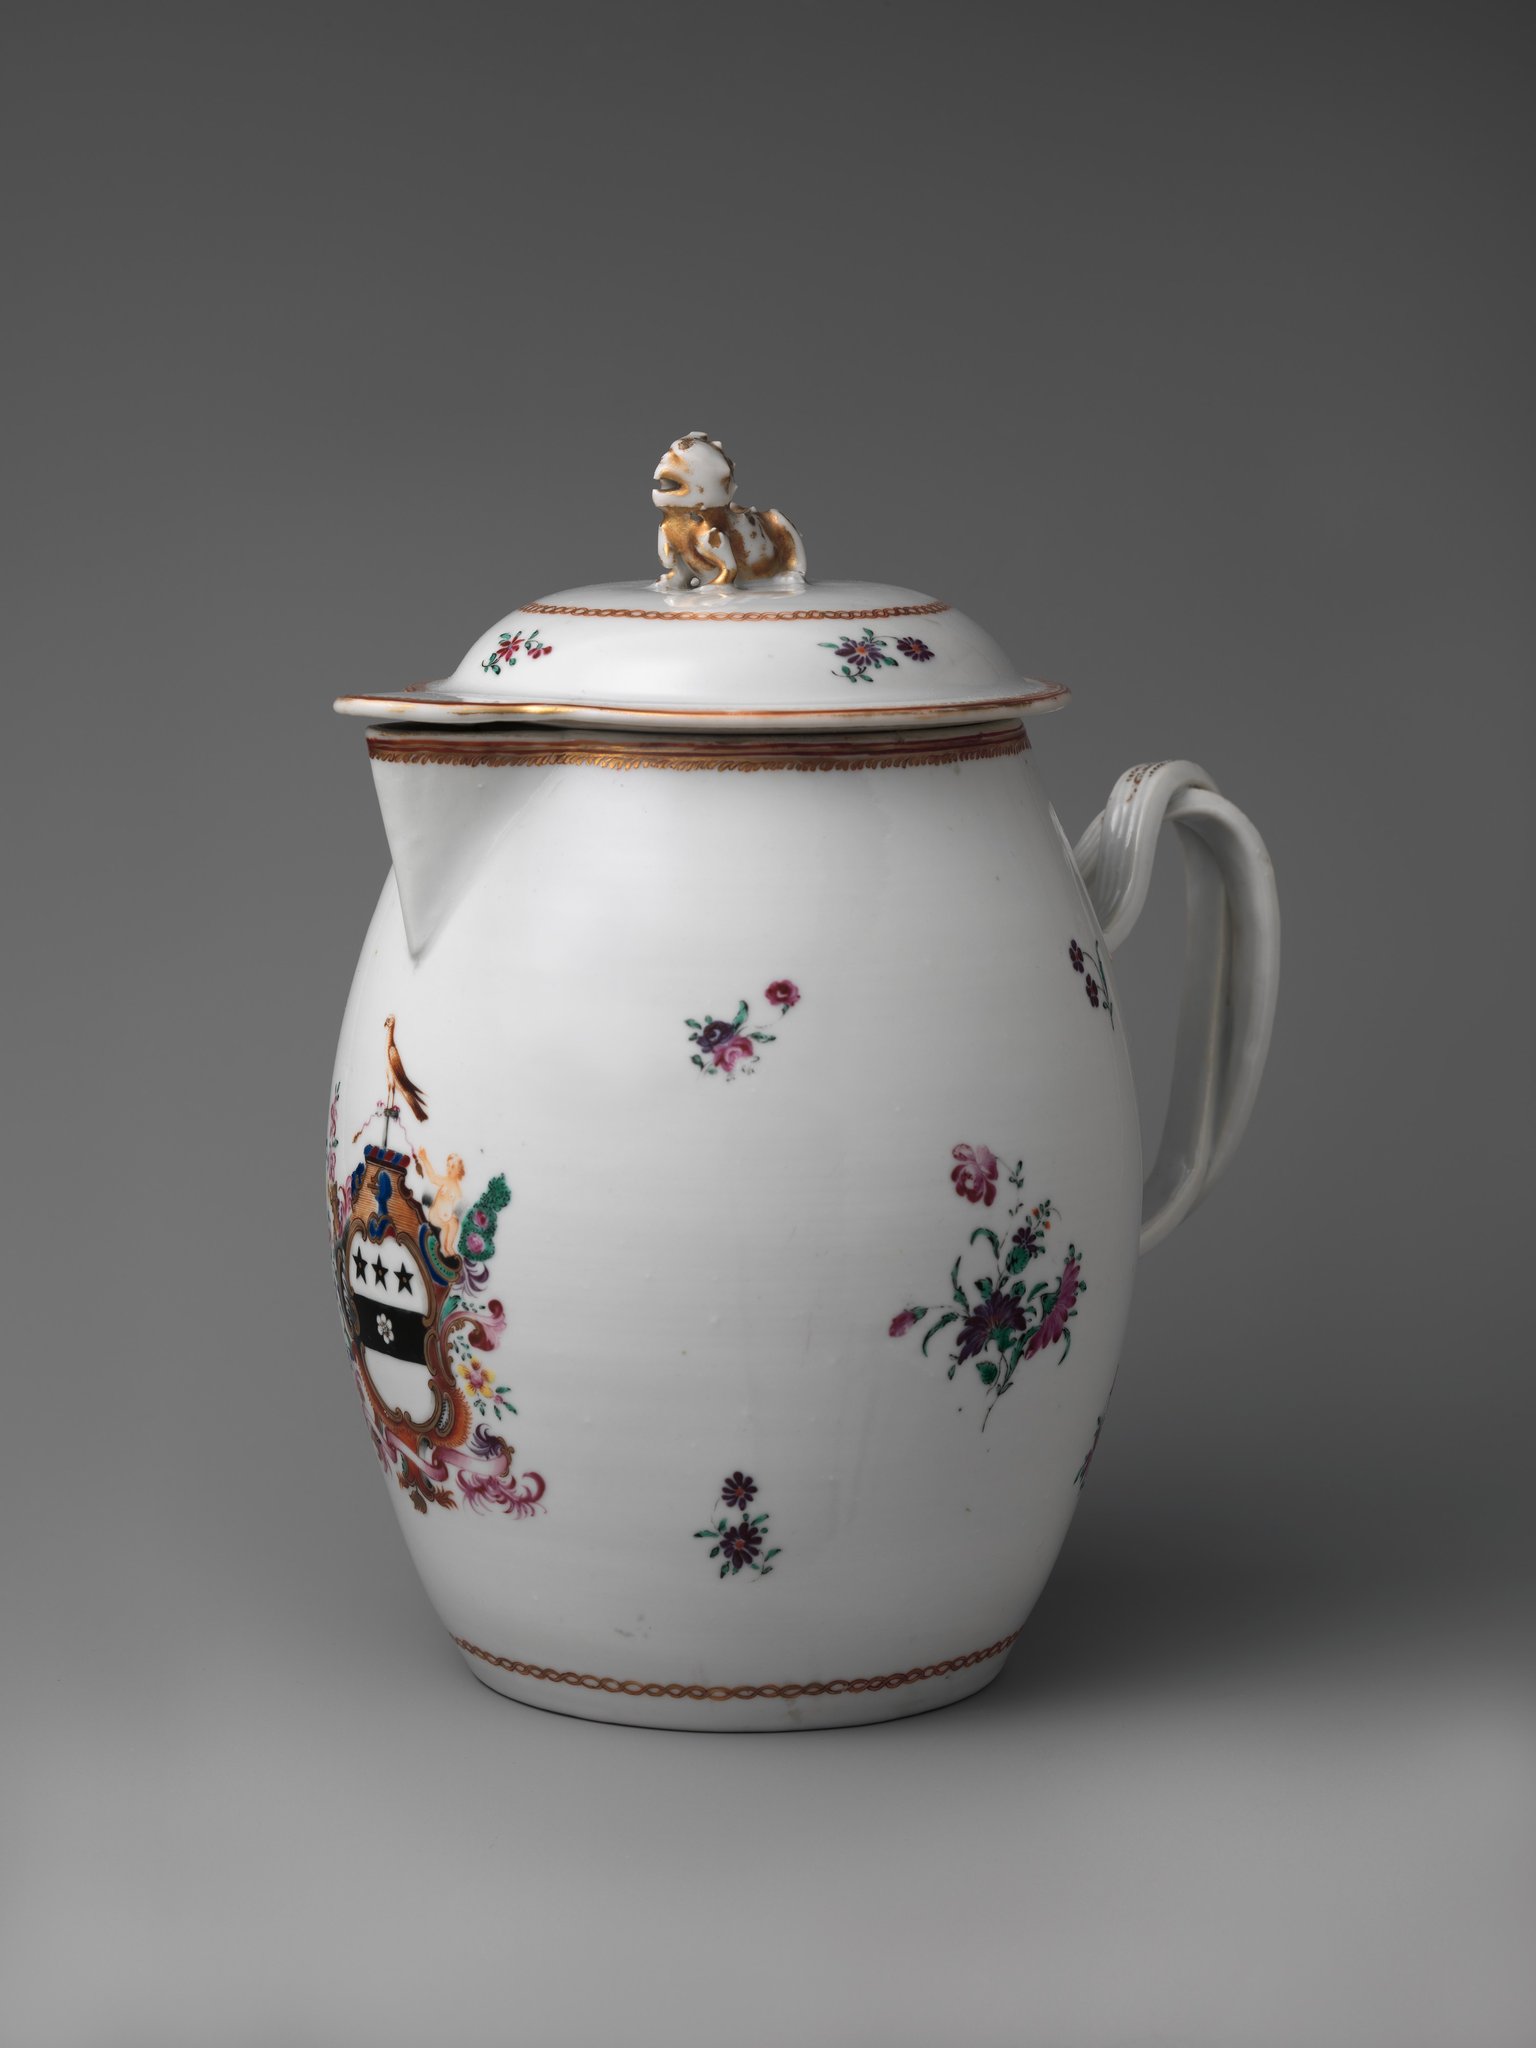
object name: pitcher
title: Covered Pitcher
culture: chinese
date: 1785-1790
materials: porcelain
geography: china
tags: birds,coat of arms